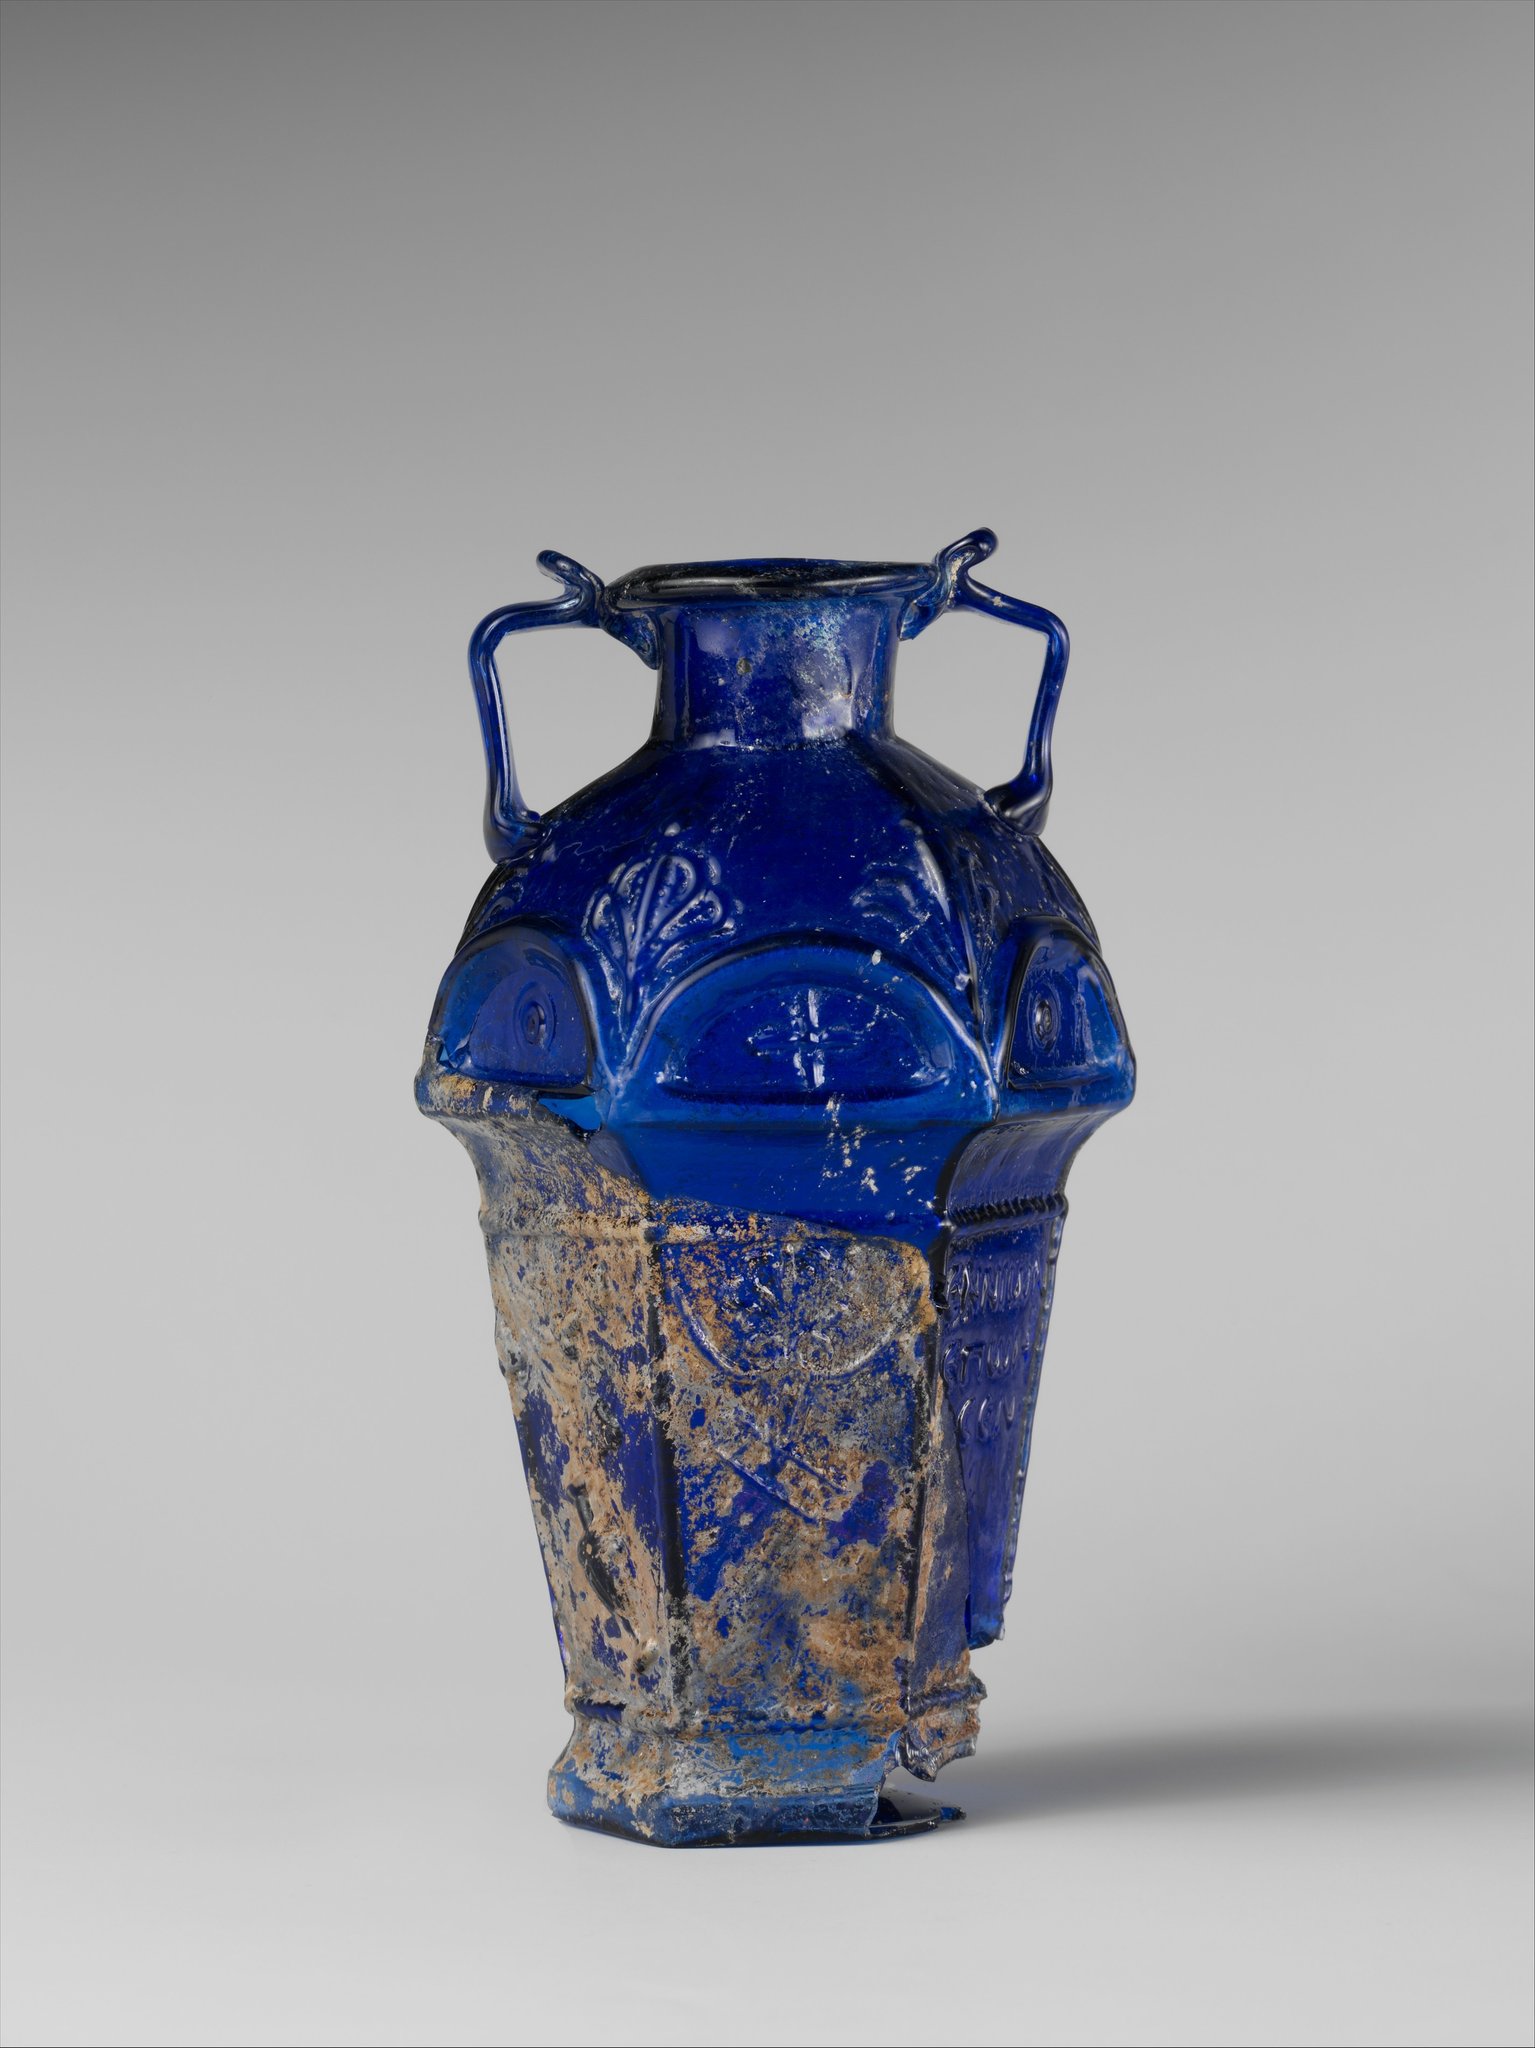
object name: amphoriskos, ennion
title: Glass hexagonal amphoriskos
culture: roman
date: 1-50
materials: glass